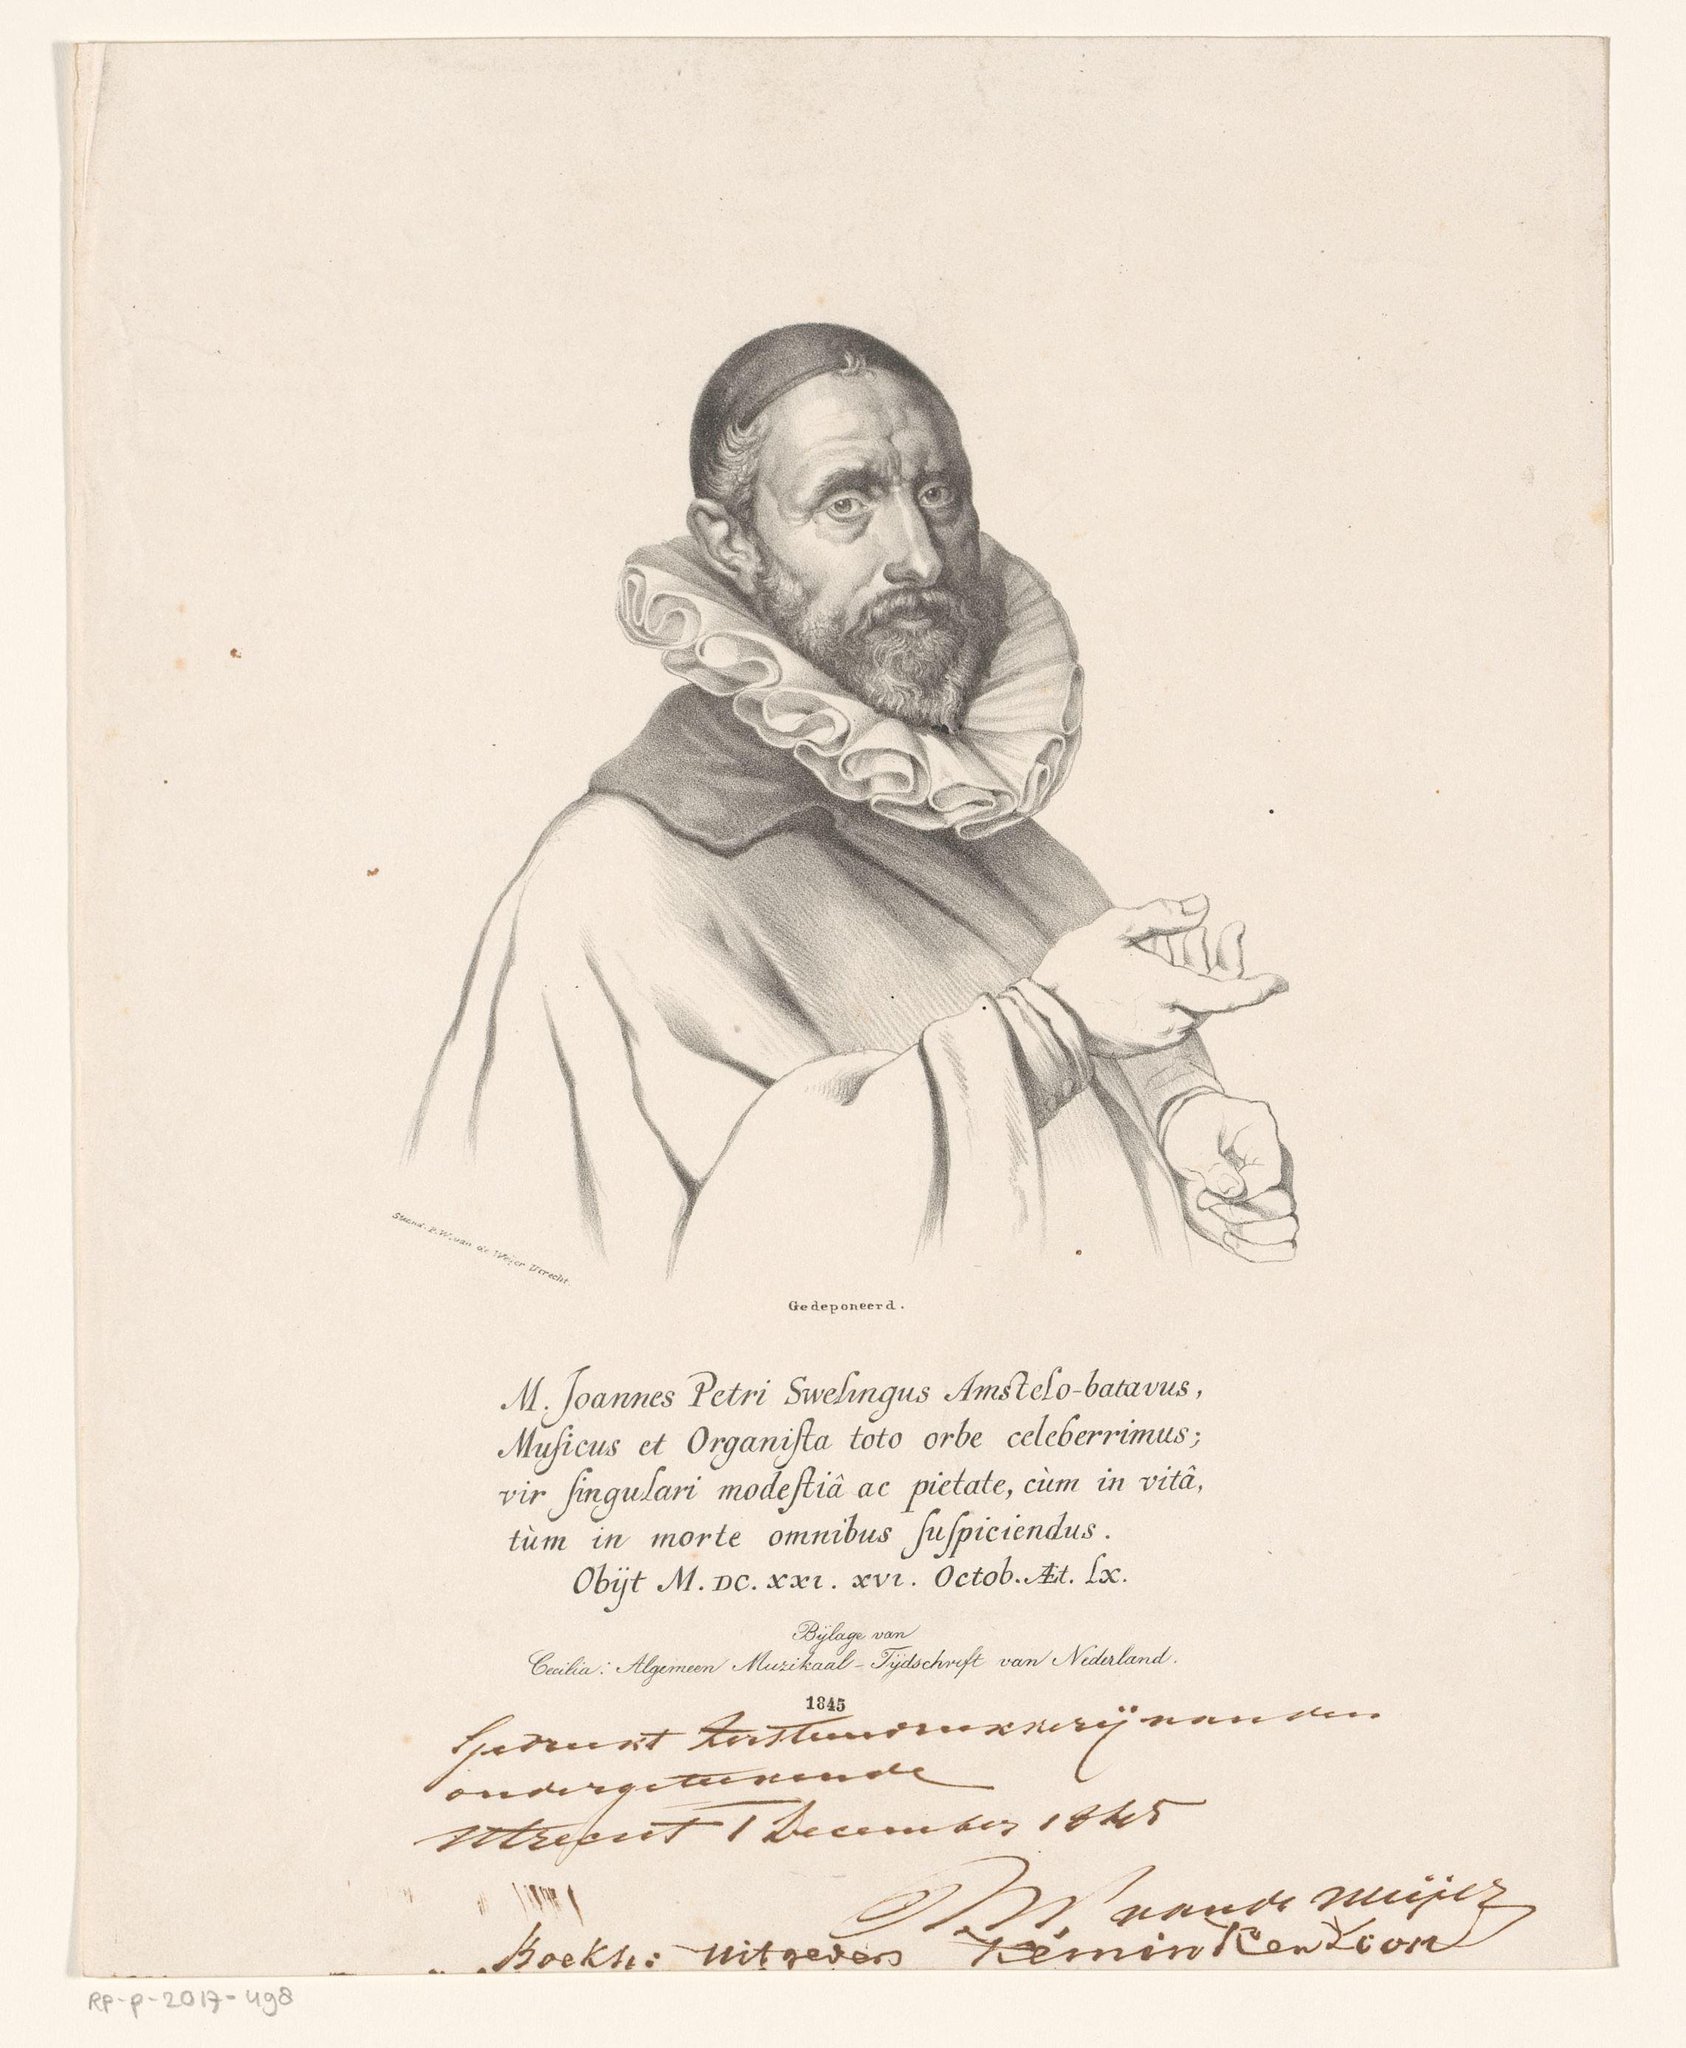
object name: print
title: Portret van Jan Pieterszoon Sweelinck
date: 1845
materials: paper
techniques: lithograph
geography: utrecht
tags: neck-gear ~ clothing (with name) (+ men's clothes), portrait of a musician, portrait of composer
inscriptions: : ‘Gedrukt ter steendrukkerij van den / ondergeteekende / Utrecht 1 december 1845 / PW van de Meijer’, : ‘(...) uitgevers Kemink & Zoon’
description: Portret van Jan Pieterszoon Sweelinck, organist en componist te Amsterdam.